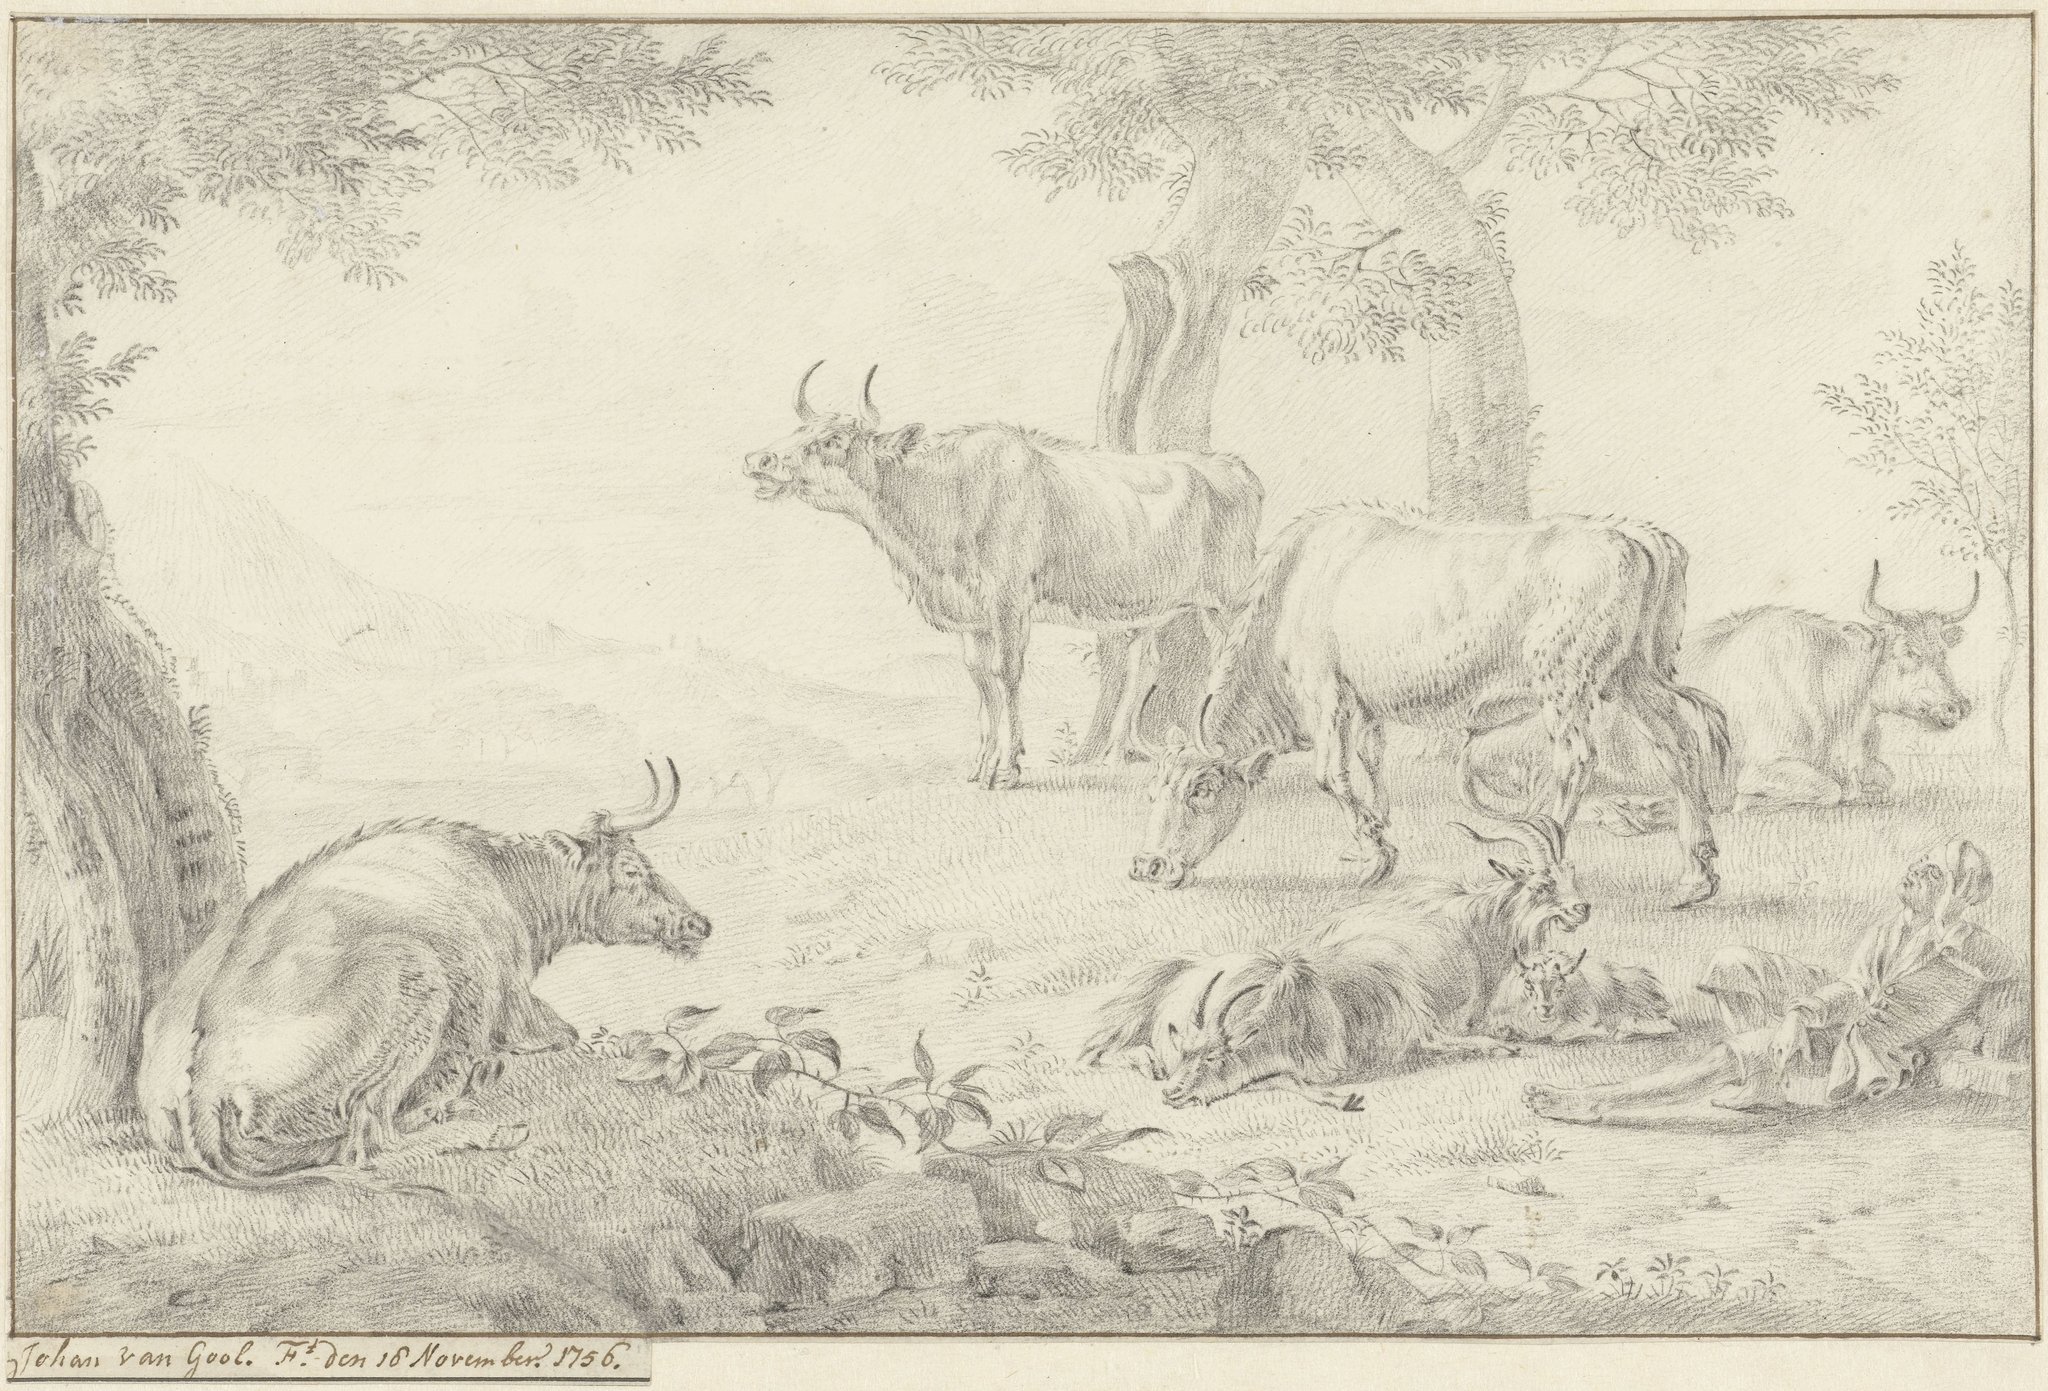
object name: drawing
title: Landschap met vee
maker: jan van gool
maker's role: draughtsman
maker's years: 1685-1763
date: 1756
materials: chalk, paper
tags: cow, goat